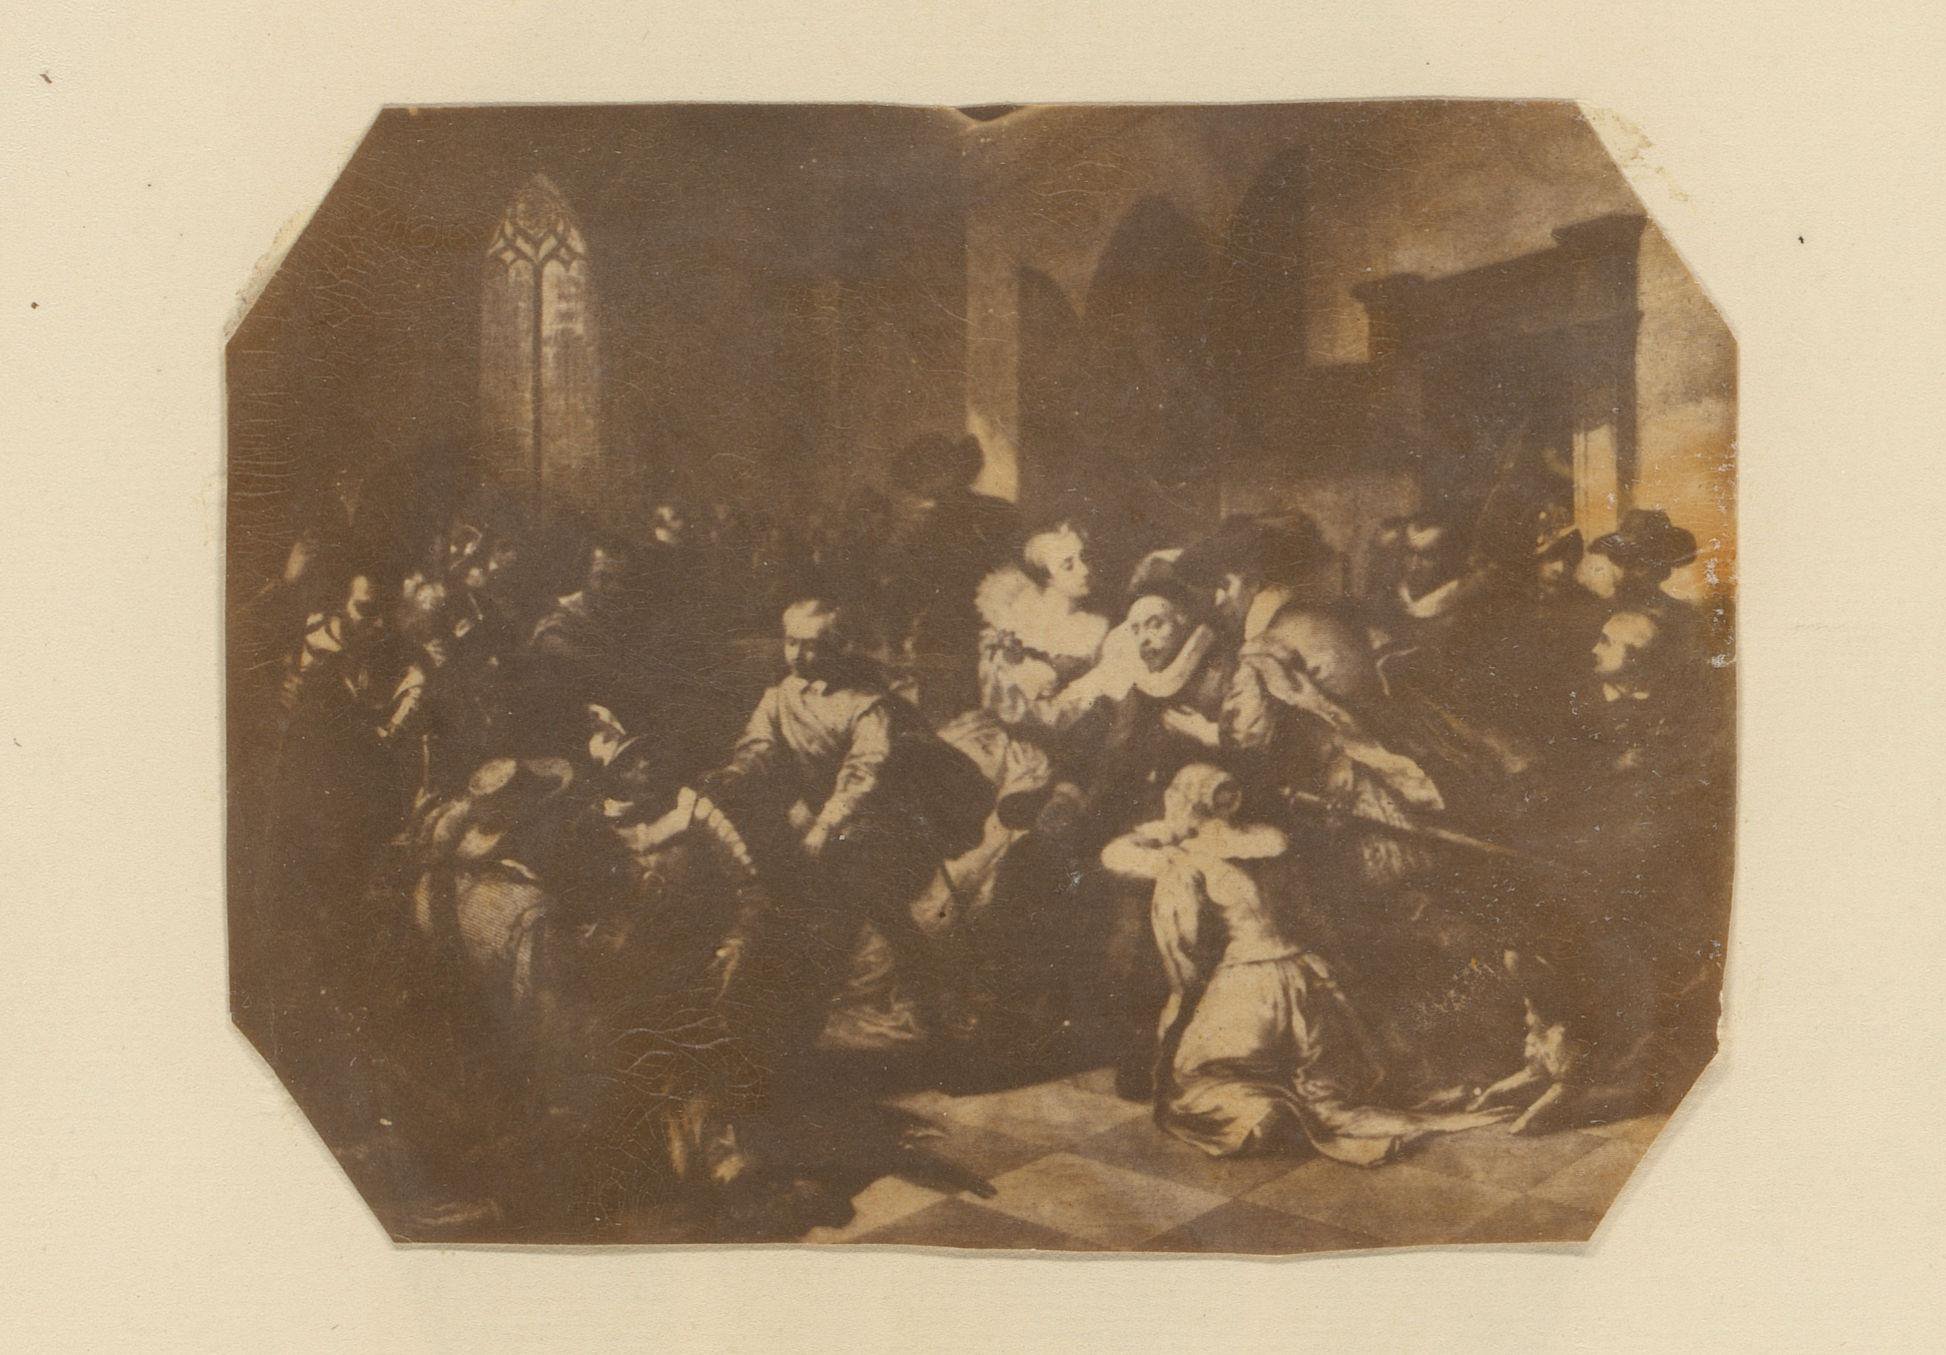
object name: photograph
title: Geschilderde kopie naar een schilderij van Nicolaas Pieneman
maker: eduard isaac asser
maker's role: amateurfotograaf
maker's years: 1809-1894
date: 1855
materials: cardboard, paper, photographic support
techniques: salted paper print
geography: amsterdam